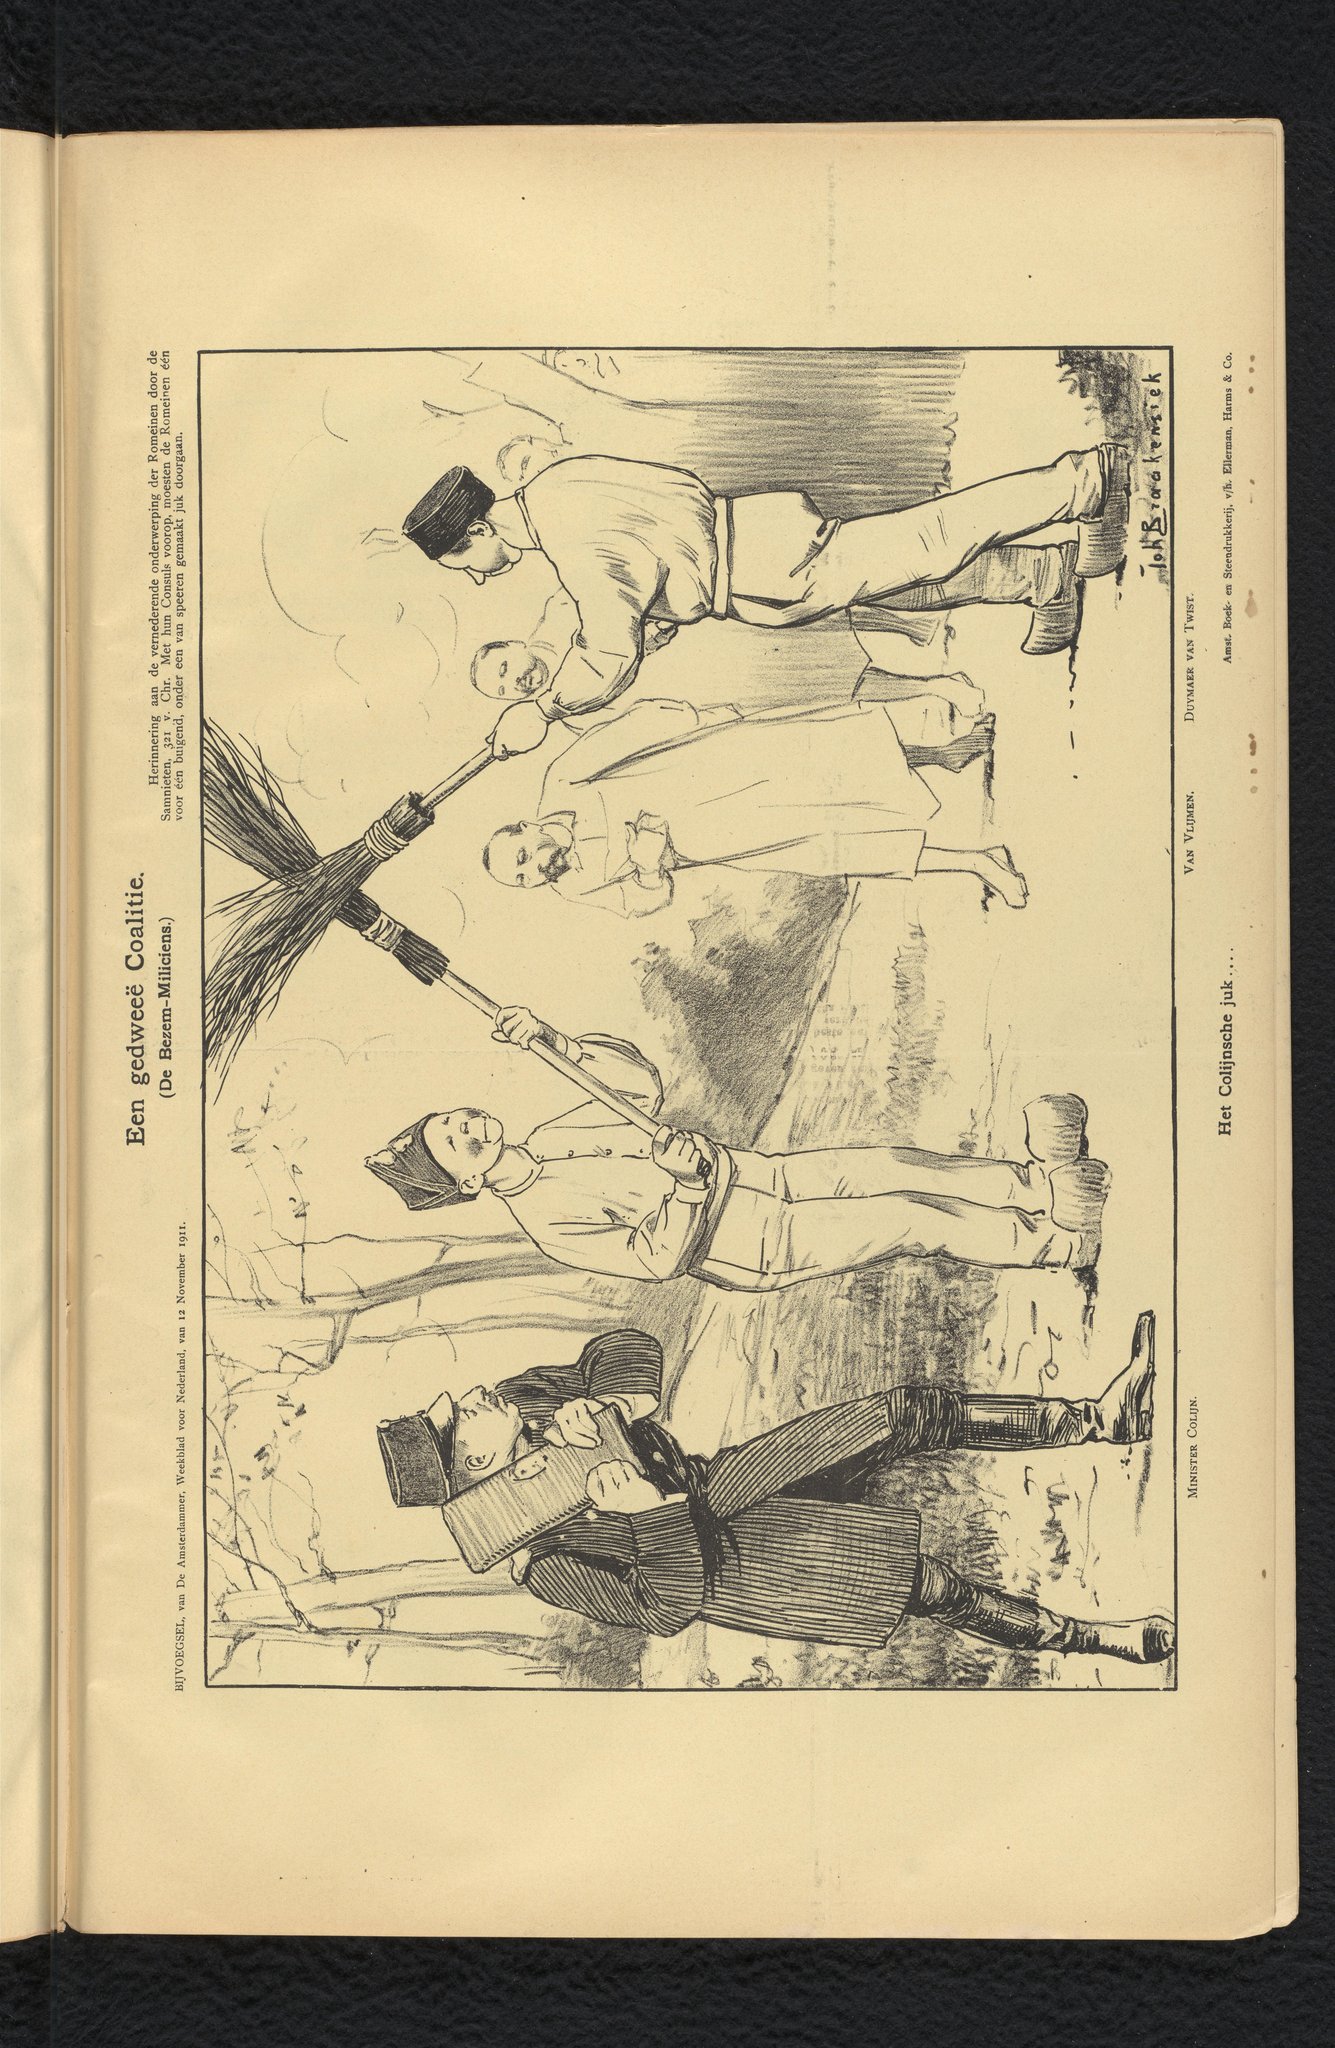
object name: cartoon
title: Een gedweeë Coalitie (De Bezem-Miliciens.)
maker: johan braakensiek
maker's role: draughtsman, print maker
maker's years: 1858-1940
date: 1911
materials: paper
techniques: lithograph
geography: amsterdam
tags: amsterdam, hendrikus colijn, the hague, military service, (household) utensils and implements (with name), political caricatures and satires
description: Kamerleden Van Vlijmen en Duymaer van Twist moeten als vernederende straf buigend onder een juk van bezems, opgehouden door dienstplichtigen, lopen. Op het einde wacht minister Colijn hen op.